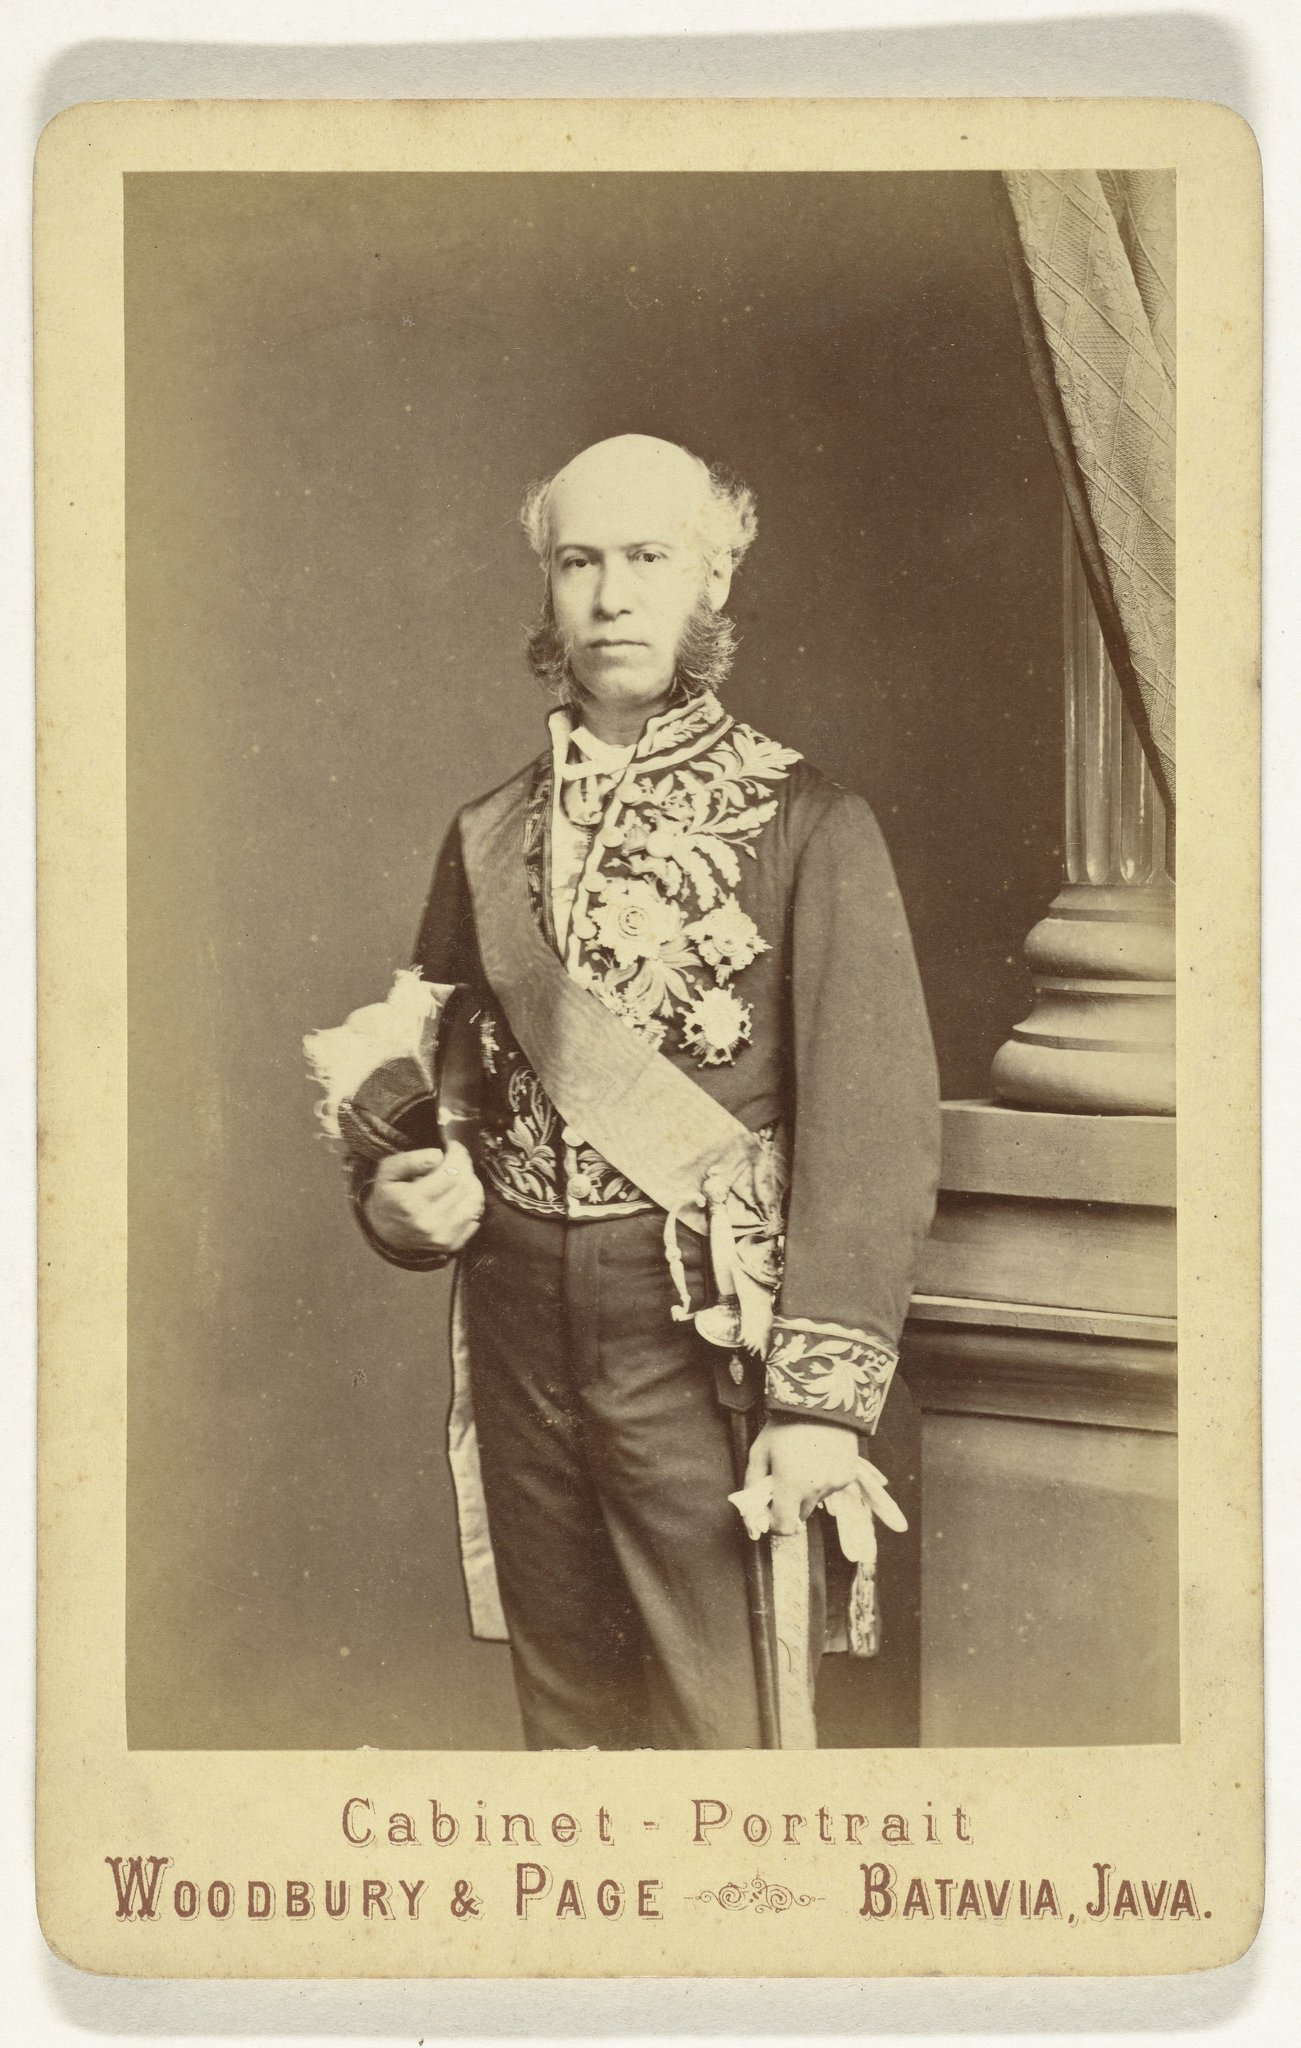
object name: photograph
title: Portret van Mr. Johan Wilhelm van Lansberge, gouverneur-generaal van Nederlands-Indië, 1875-1881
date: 1875-1881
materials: paper, photographic support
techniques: albumen print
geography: batavia